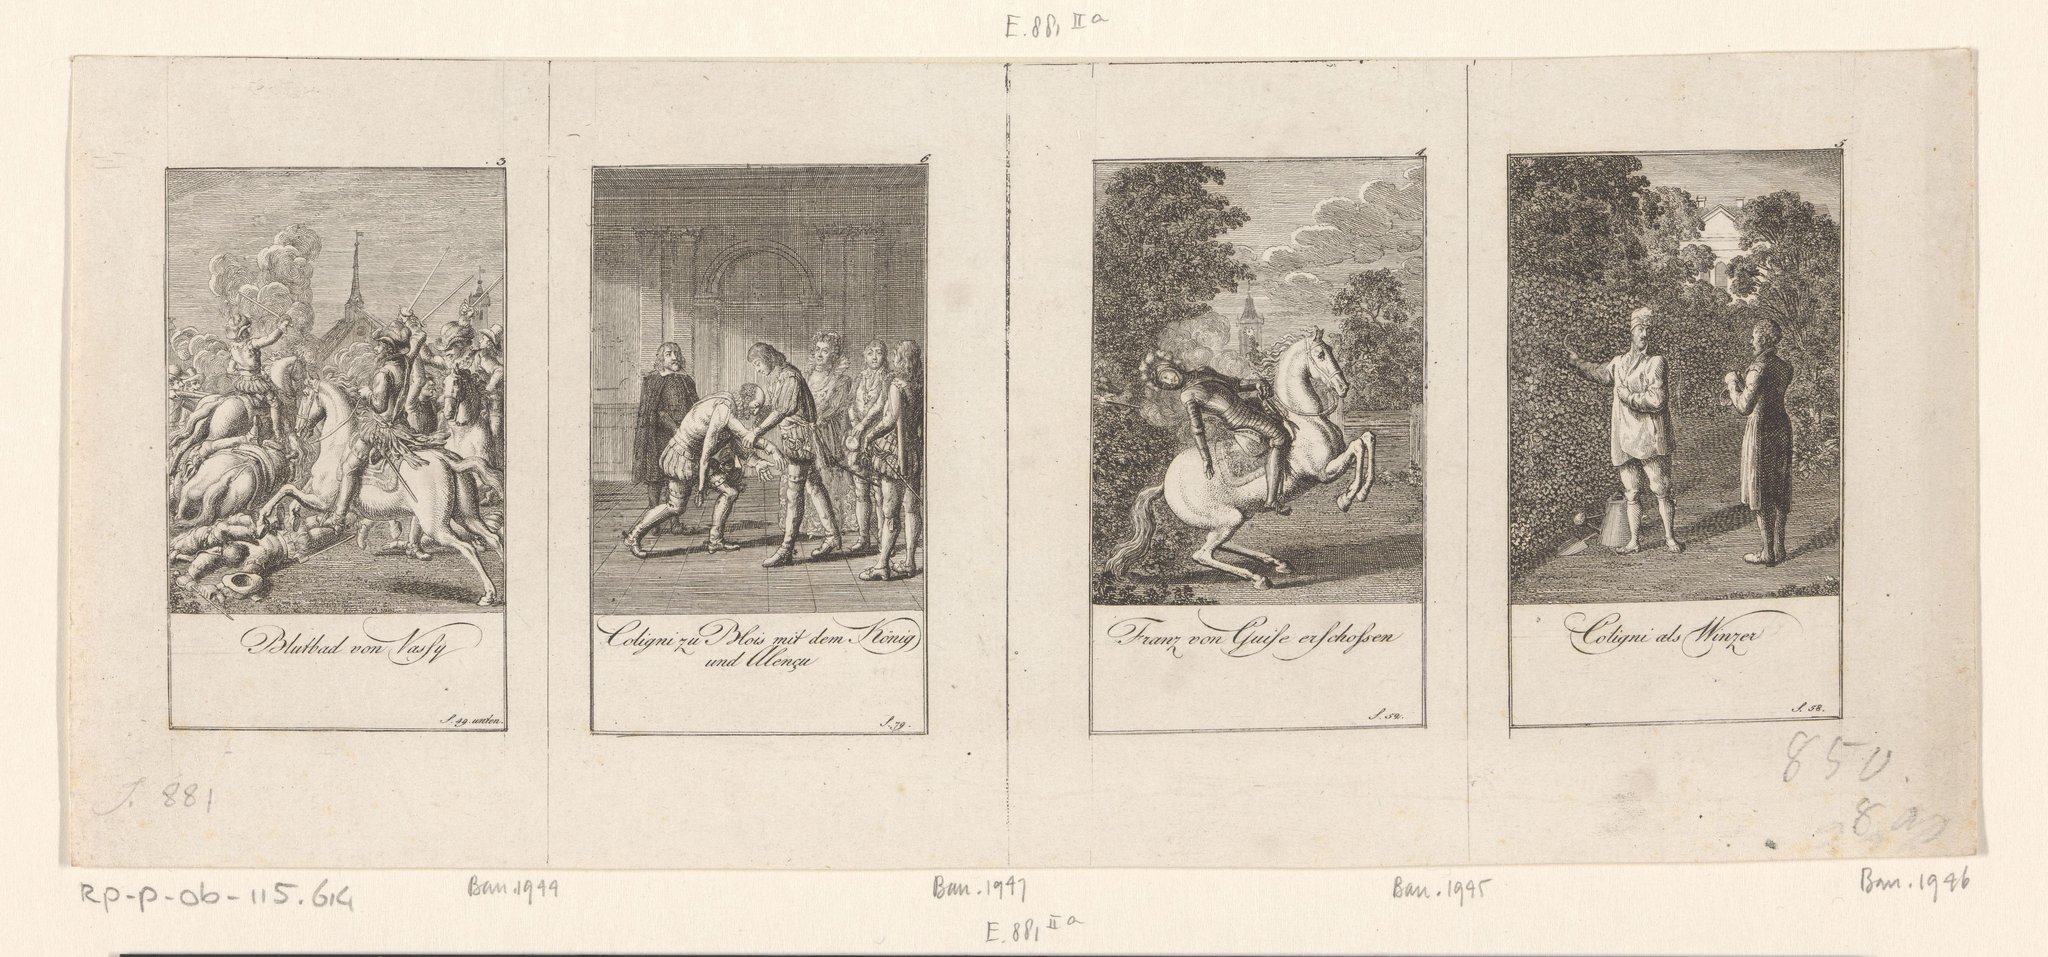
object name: print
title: Vier voorstellingen uit de geschiedenis van de Bartholomeusnacht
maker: daniel nikolaus chodowiecki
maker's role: draughtsman, print maker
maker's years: 1726-1801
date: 1797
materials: paper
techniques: etching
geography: berlin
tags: paris, politician, gaspard de coligny (ii), introducing, (military) espionage, battle, murder, kneeling figure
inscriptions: collector's mark: Lugt 2228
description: Prenten gebruikt voor: Historisch-genealogischer Kalender auf das Jahr 1799 und 1800. Die Geschichte der Bartholomäusnacht oder die Bluthochzeit zu Paris. Berlijn: Johann Friedrich Unger, [1798].